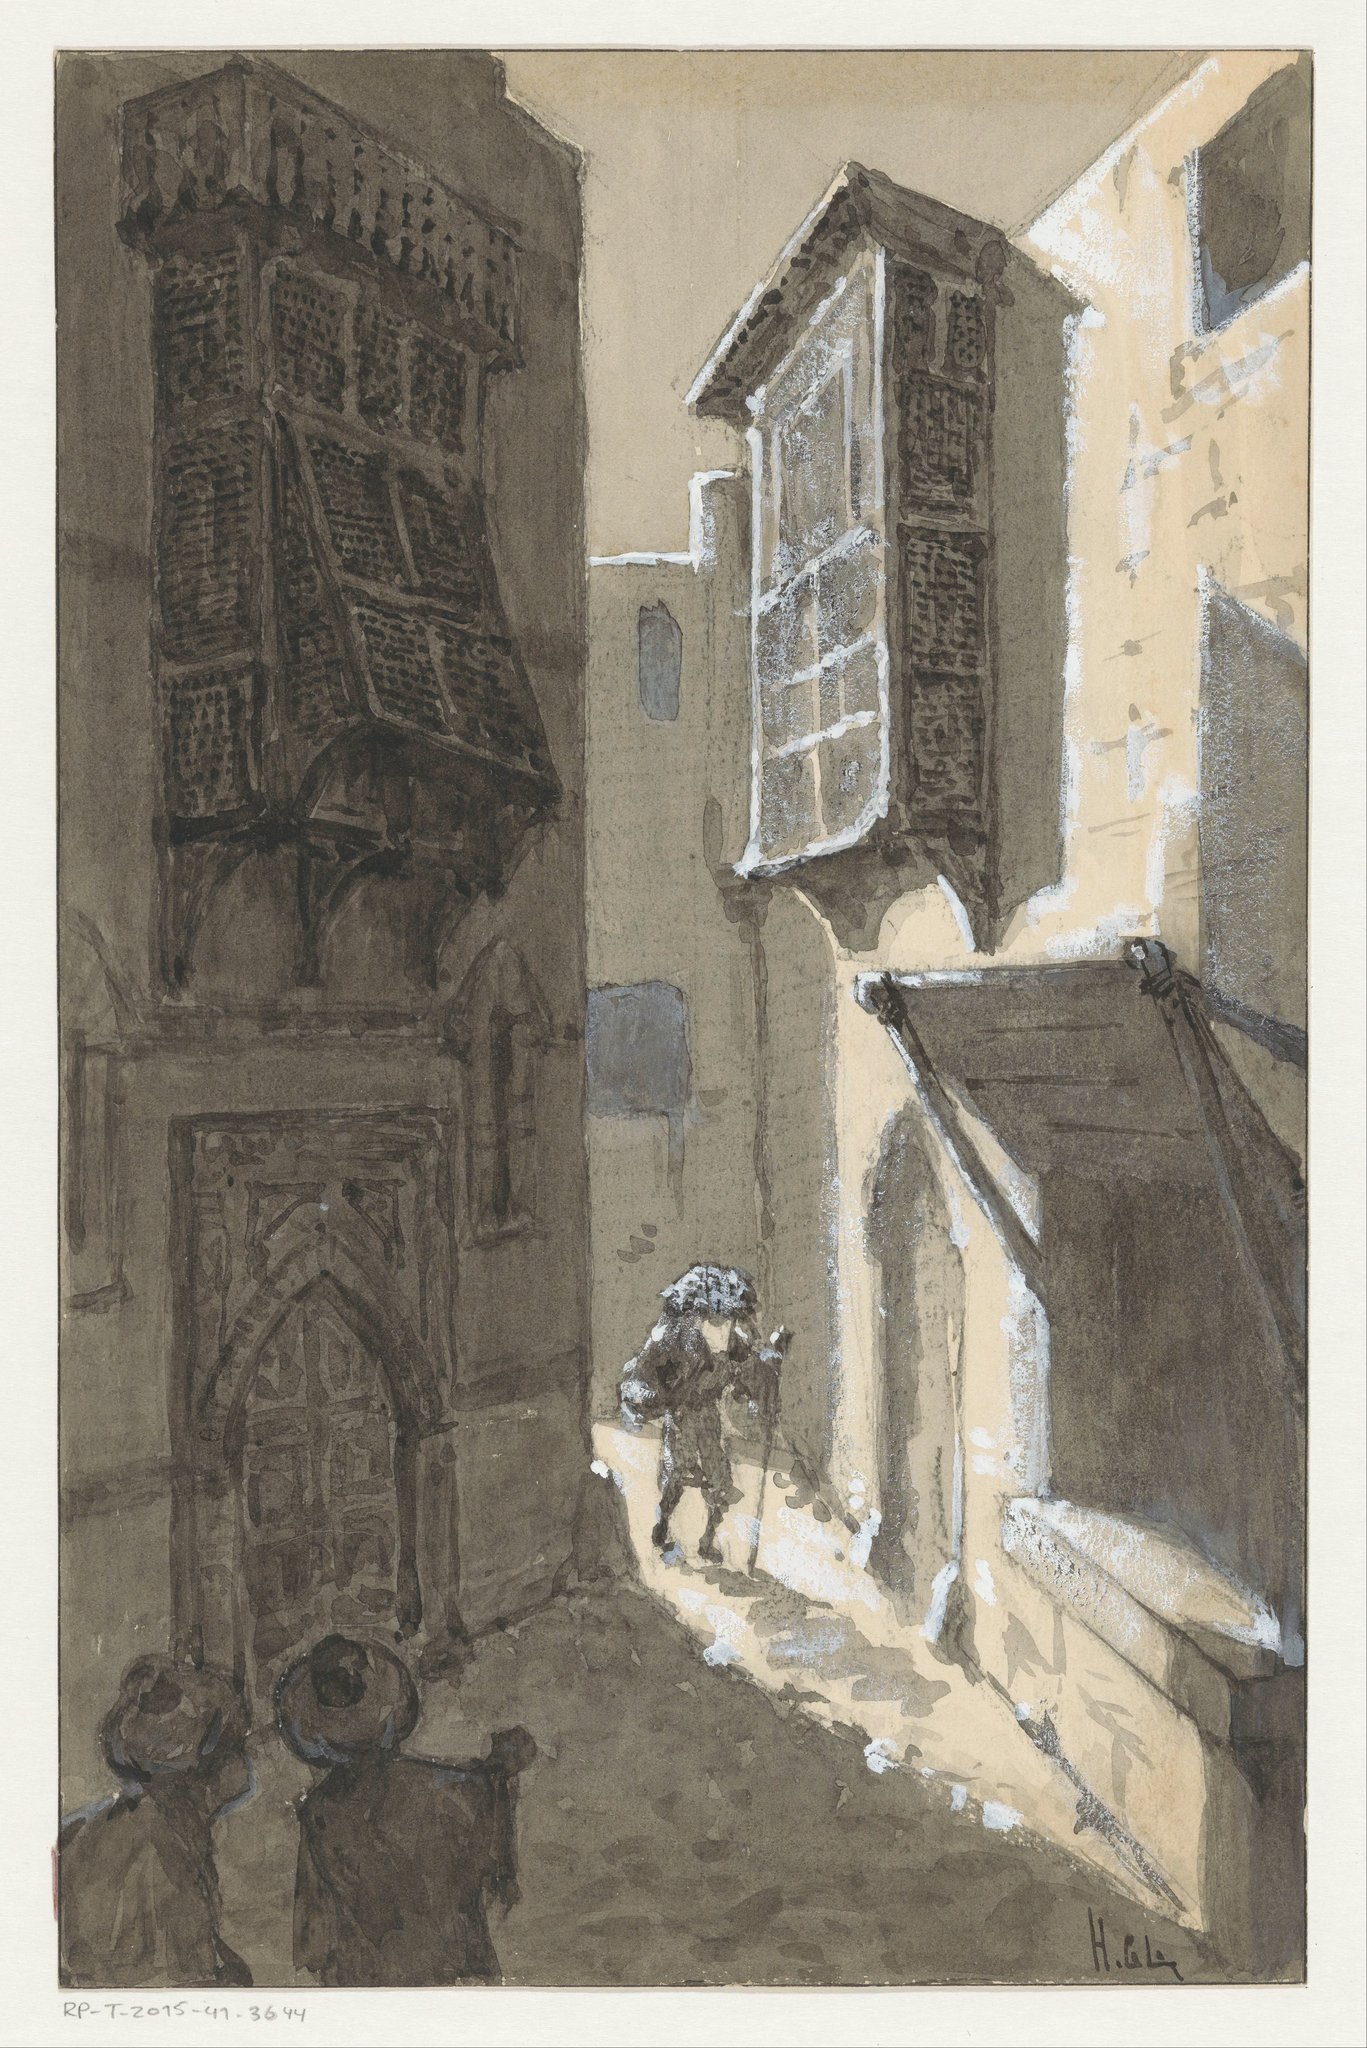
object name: boekillustratie ontwerp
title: Man met bepakking in een straat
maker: h.c. louwerse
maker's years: 1878-1946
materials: paint, paper, pencil, watercolor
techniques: brush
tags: luggage, travel requisites, walking-stick, staff, street (+ city(-scape) with figures, staffage)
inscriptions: collector's mark: Lugt 2228a, number: ‘No 1303’, signature: ‘H.C.L.’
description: Een man loopt met een pakket op zijn rug en een stok in de hand door een nauwe straat. In de voorgrond staan twee figuren met tulbanden.